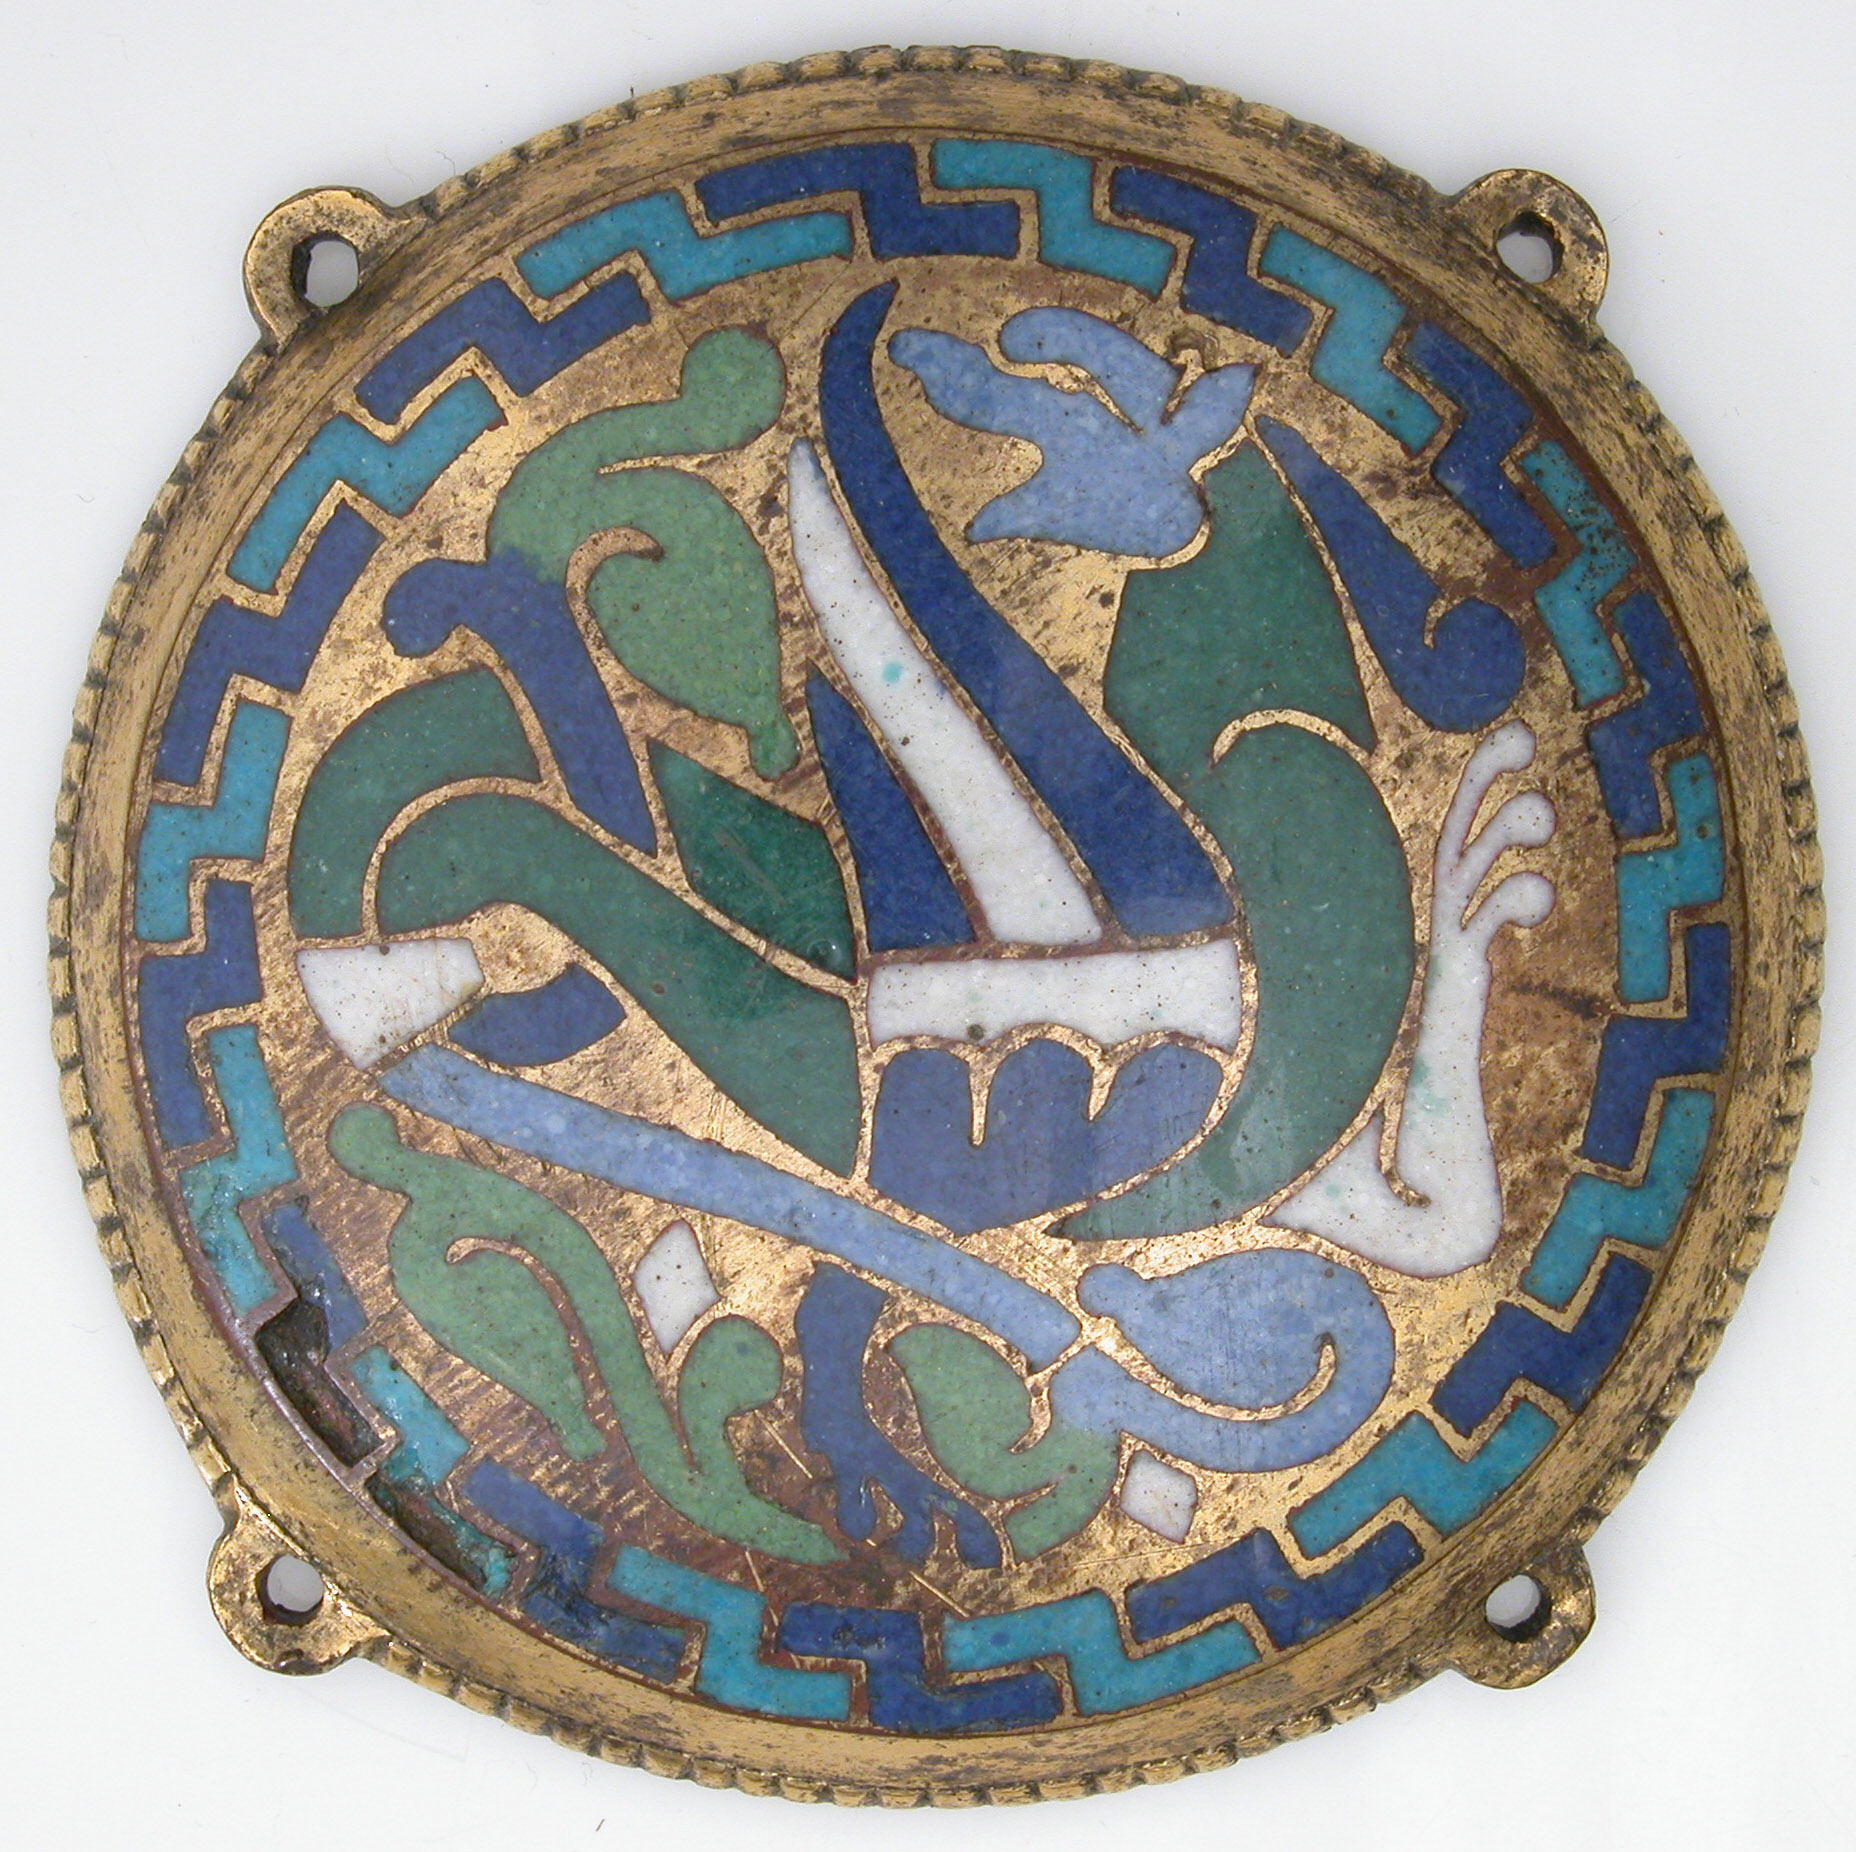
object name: medallion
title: Winged Dragon (one of five medallions from a coffret)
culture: french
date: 1110-1130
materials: gilt copper, enamel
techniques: enamel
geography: france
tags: dragons